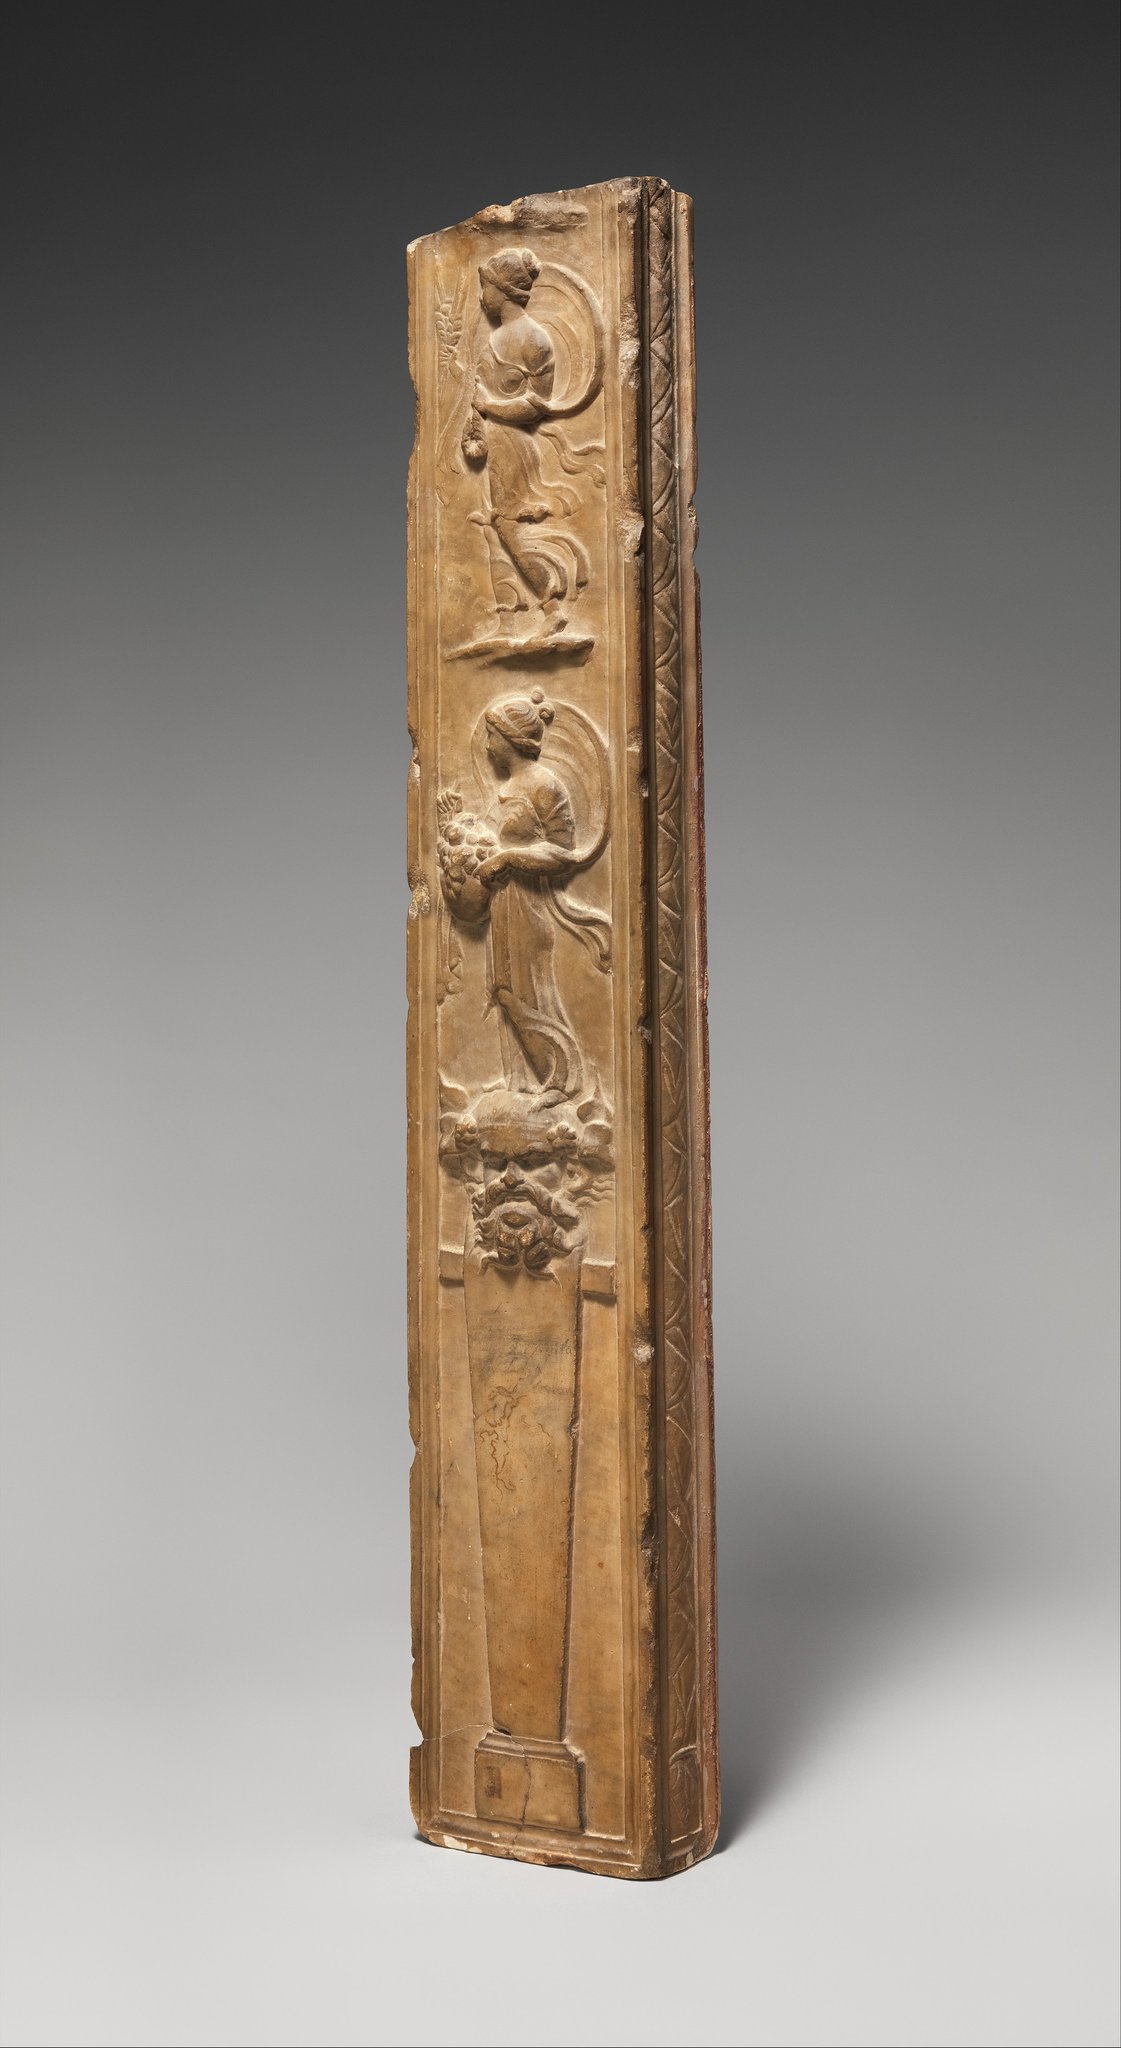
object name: pillar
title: Marble pillar with Neo-Attic reliefs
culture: roman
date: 34 BCE-33 CE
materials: marble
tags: women,silenus